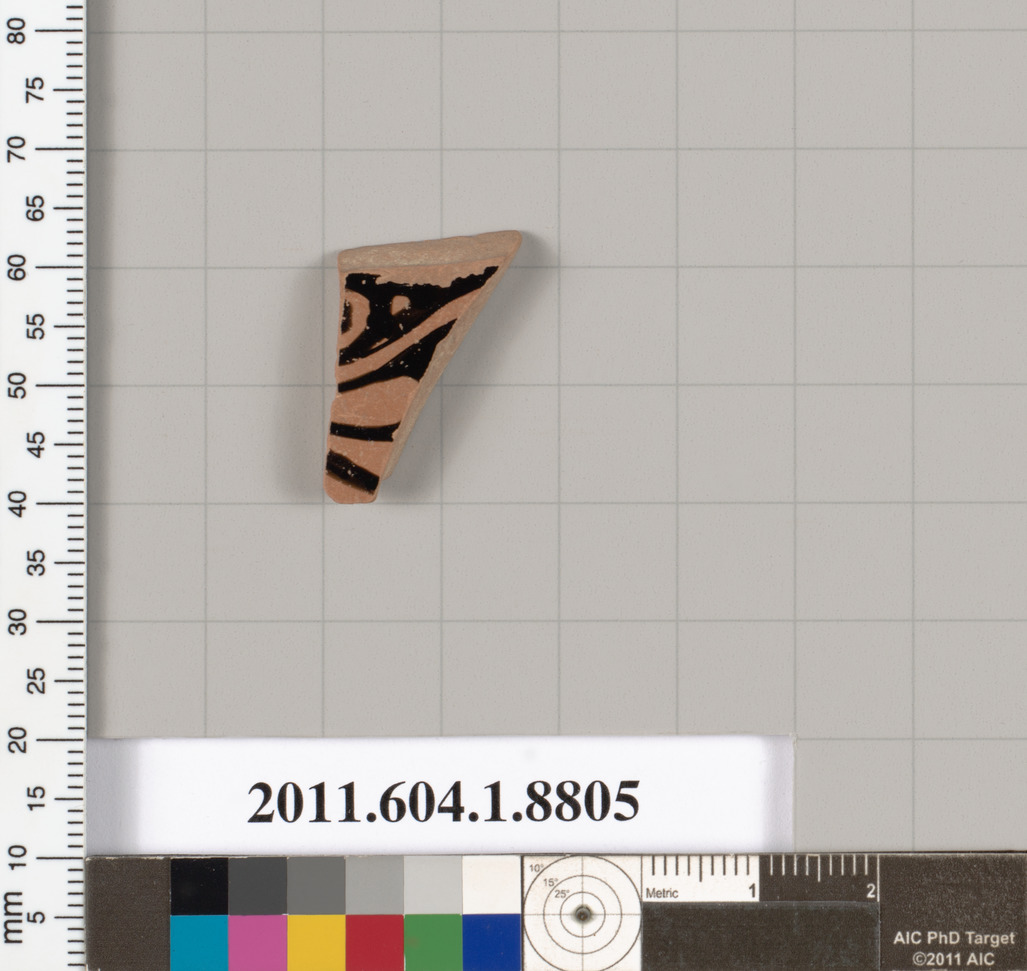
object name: kylix fragment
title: Terracotta fragment of a kylix (drinking cup)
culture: greek, attic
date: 490-480 BCE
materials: terracotta